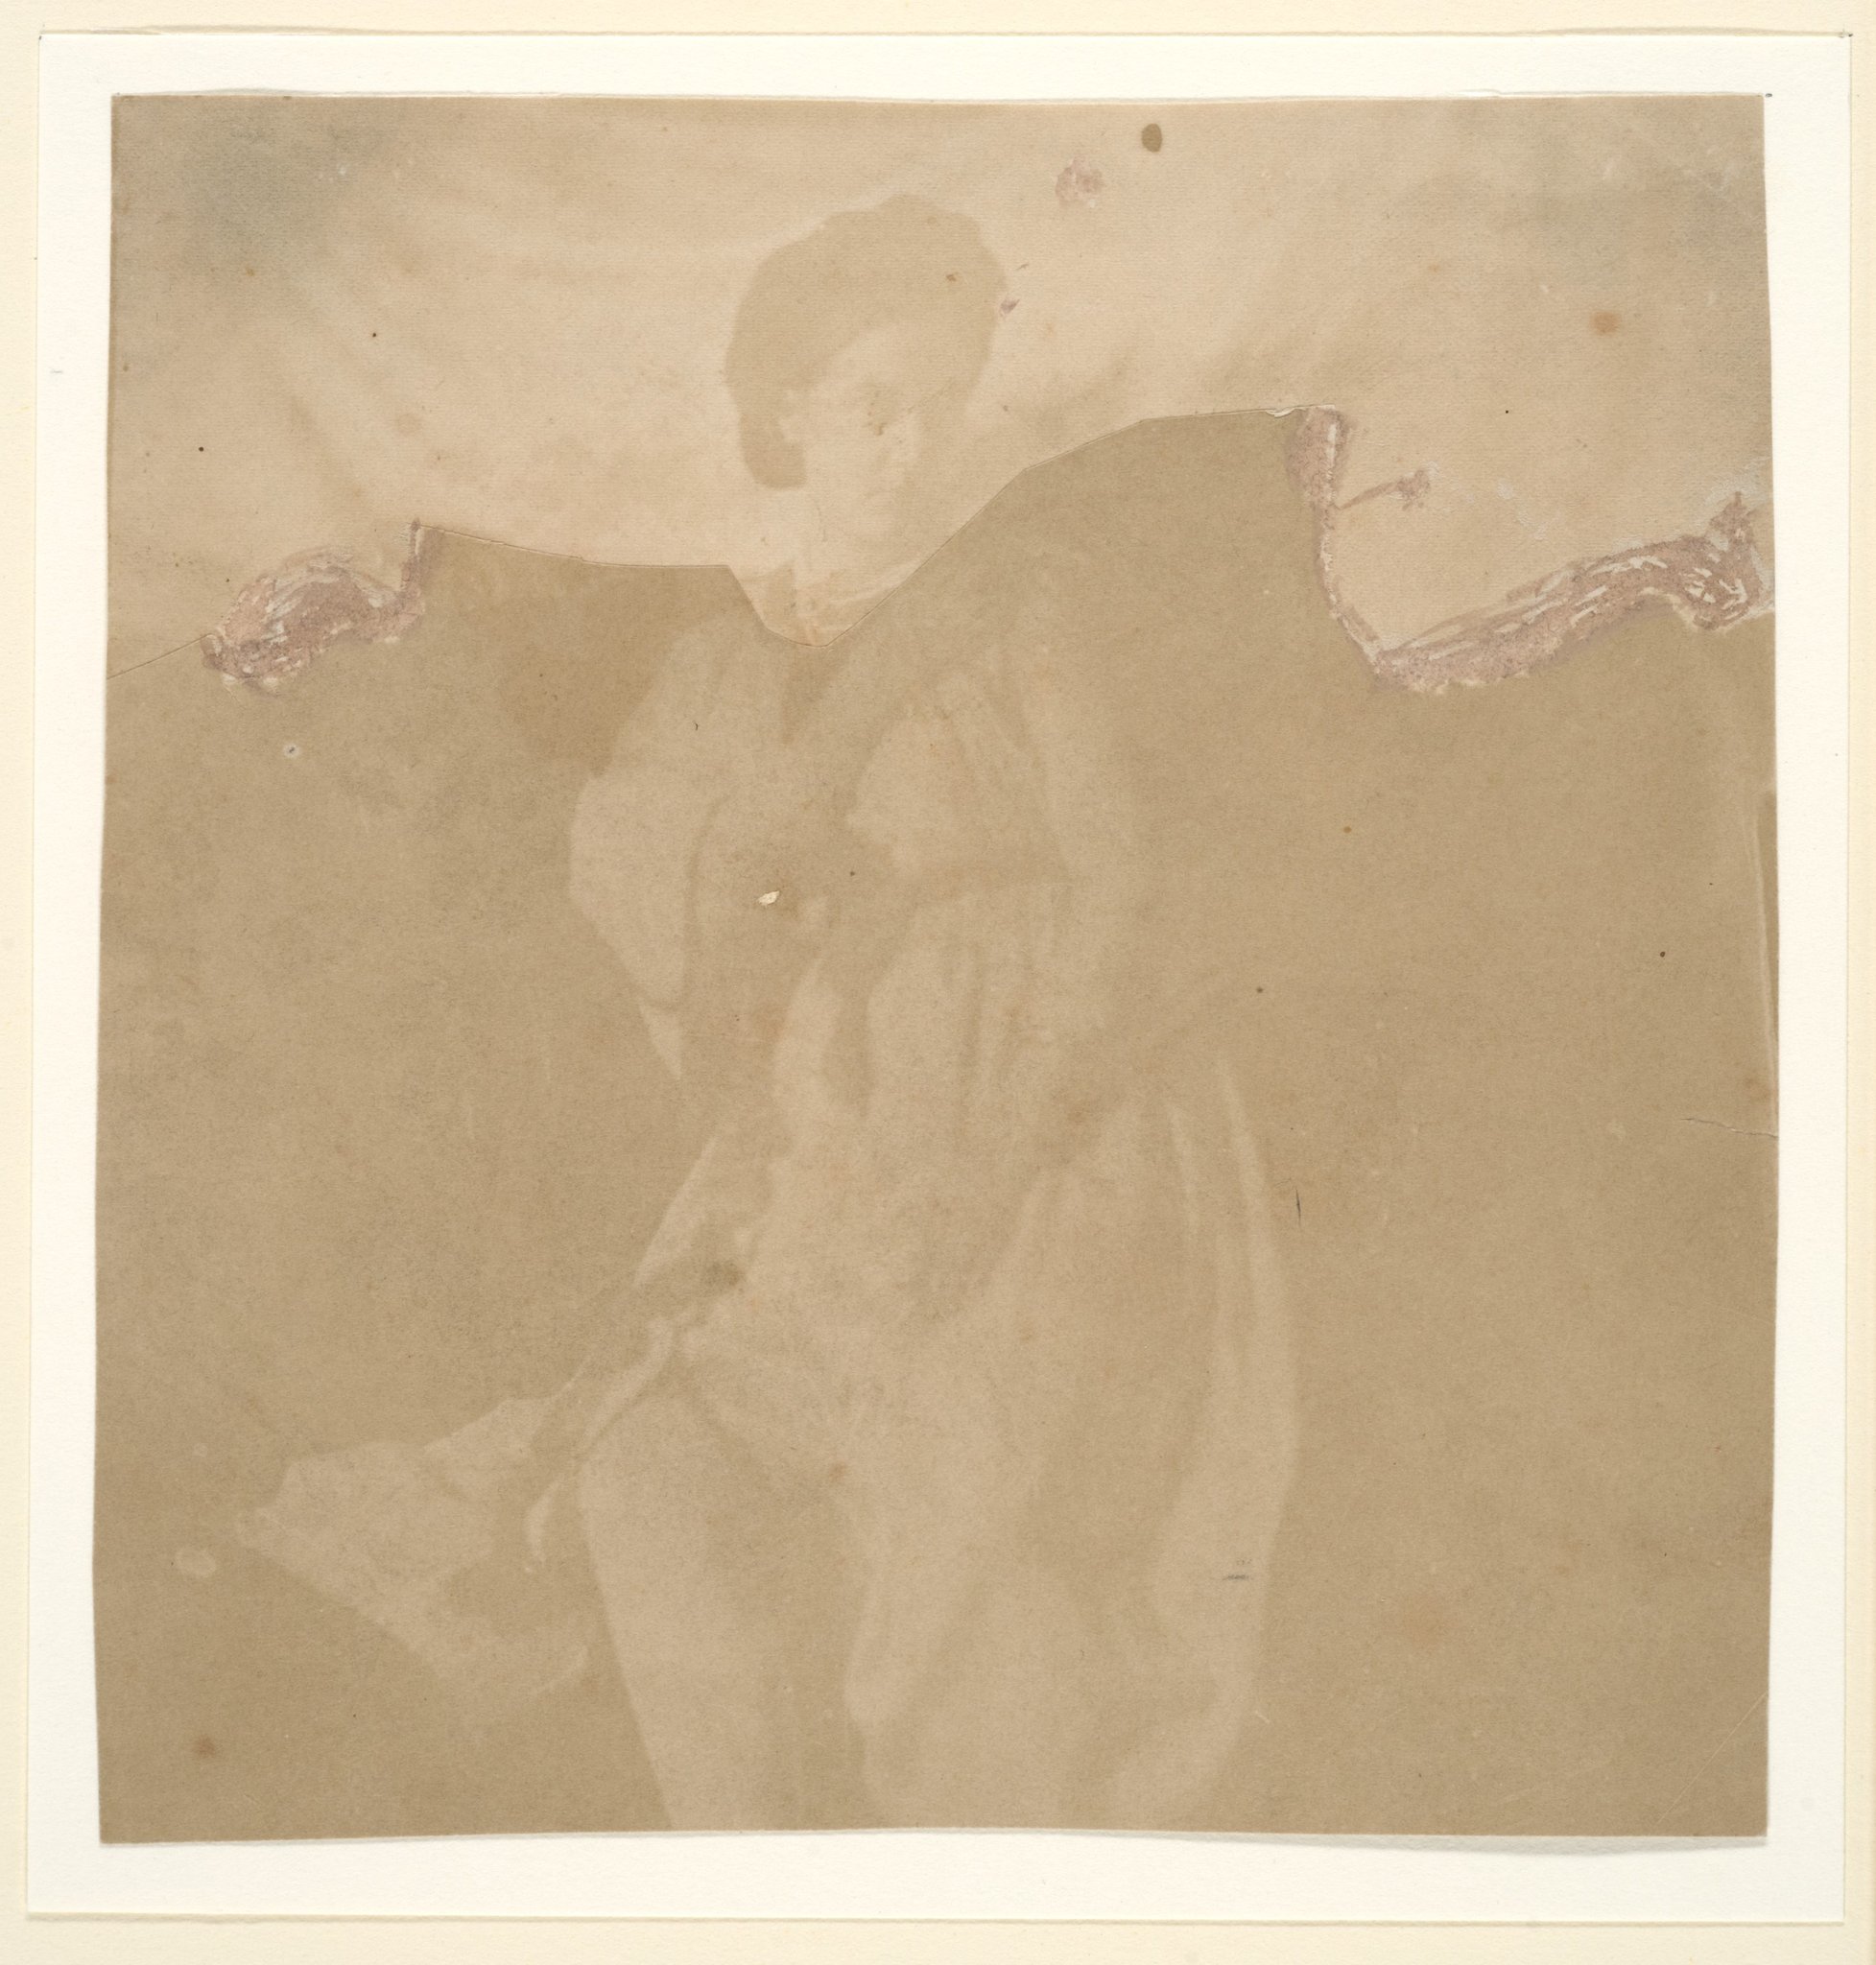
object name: photograph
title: La Coucher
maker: pierre-louis pierson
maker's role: artist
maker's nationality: french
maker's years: 1822-1913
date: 1860-1869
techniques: glass negative, salted paper print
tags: portraits,women